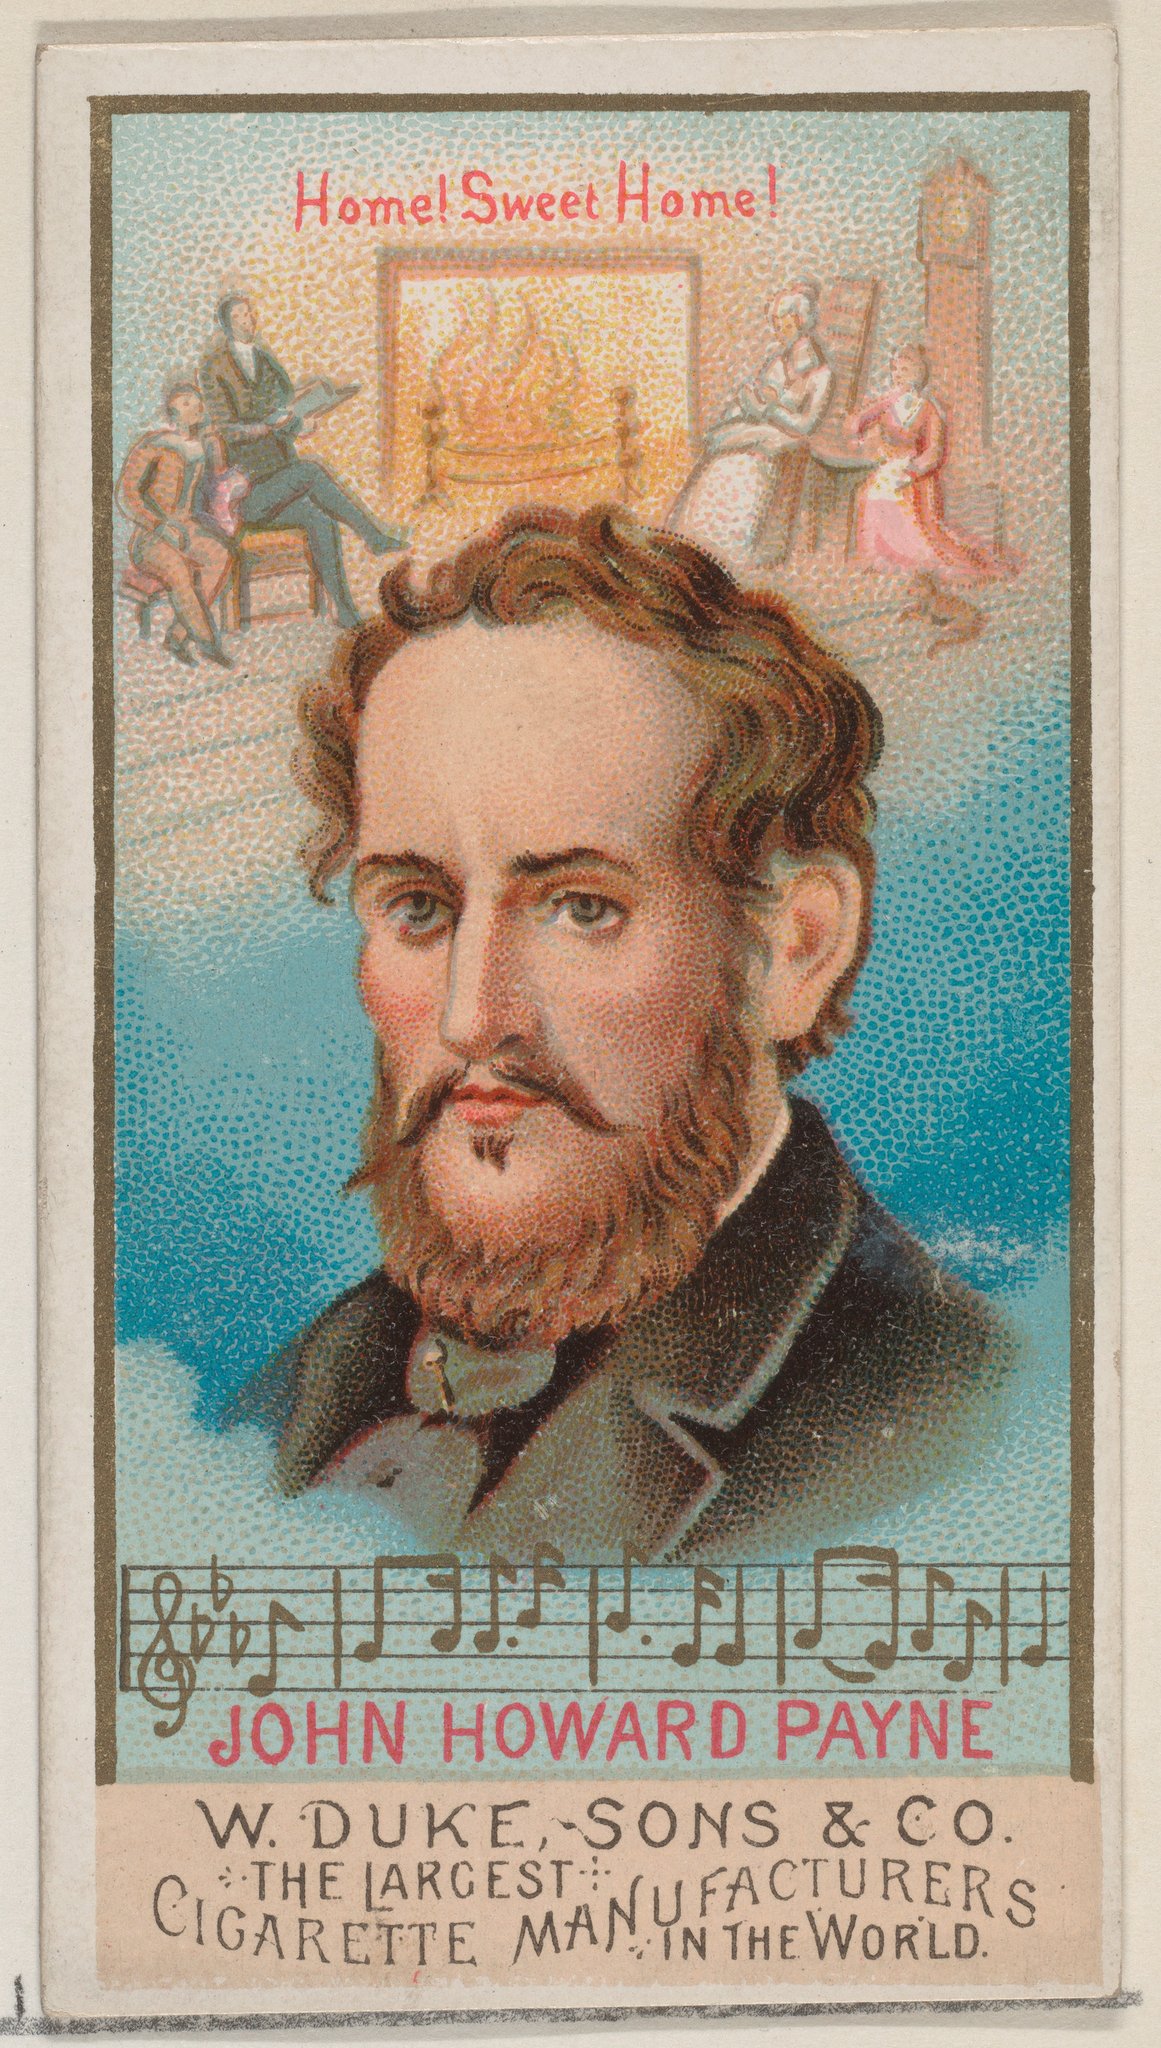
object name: print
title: John Howard Payne, from the series Great Americans (N76) for Duke brand cigarettes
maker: w. duke, sons & co.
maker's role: publisher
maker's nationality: american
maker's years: 1870-1920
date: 1888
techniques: color lithograph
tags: men